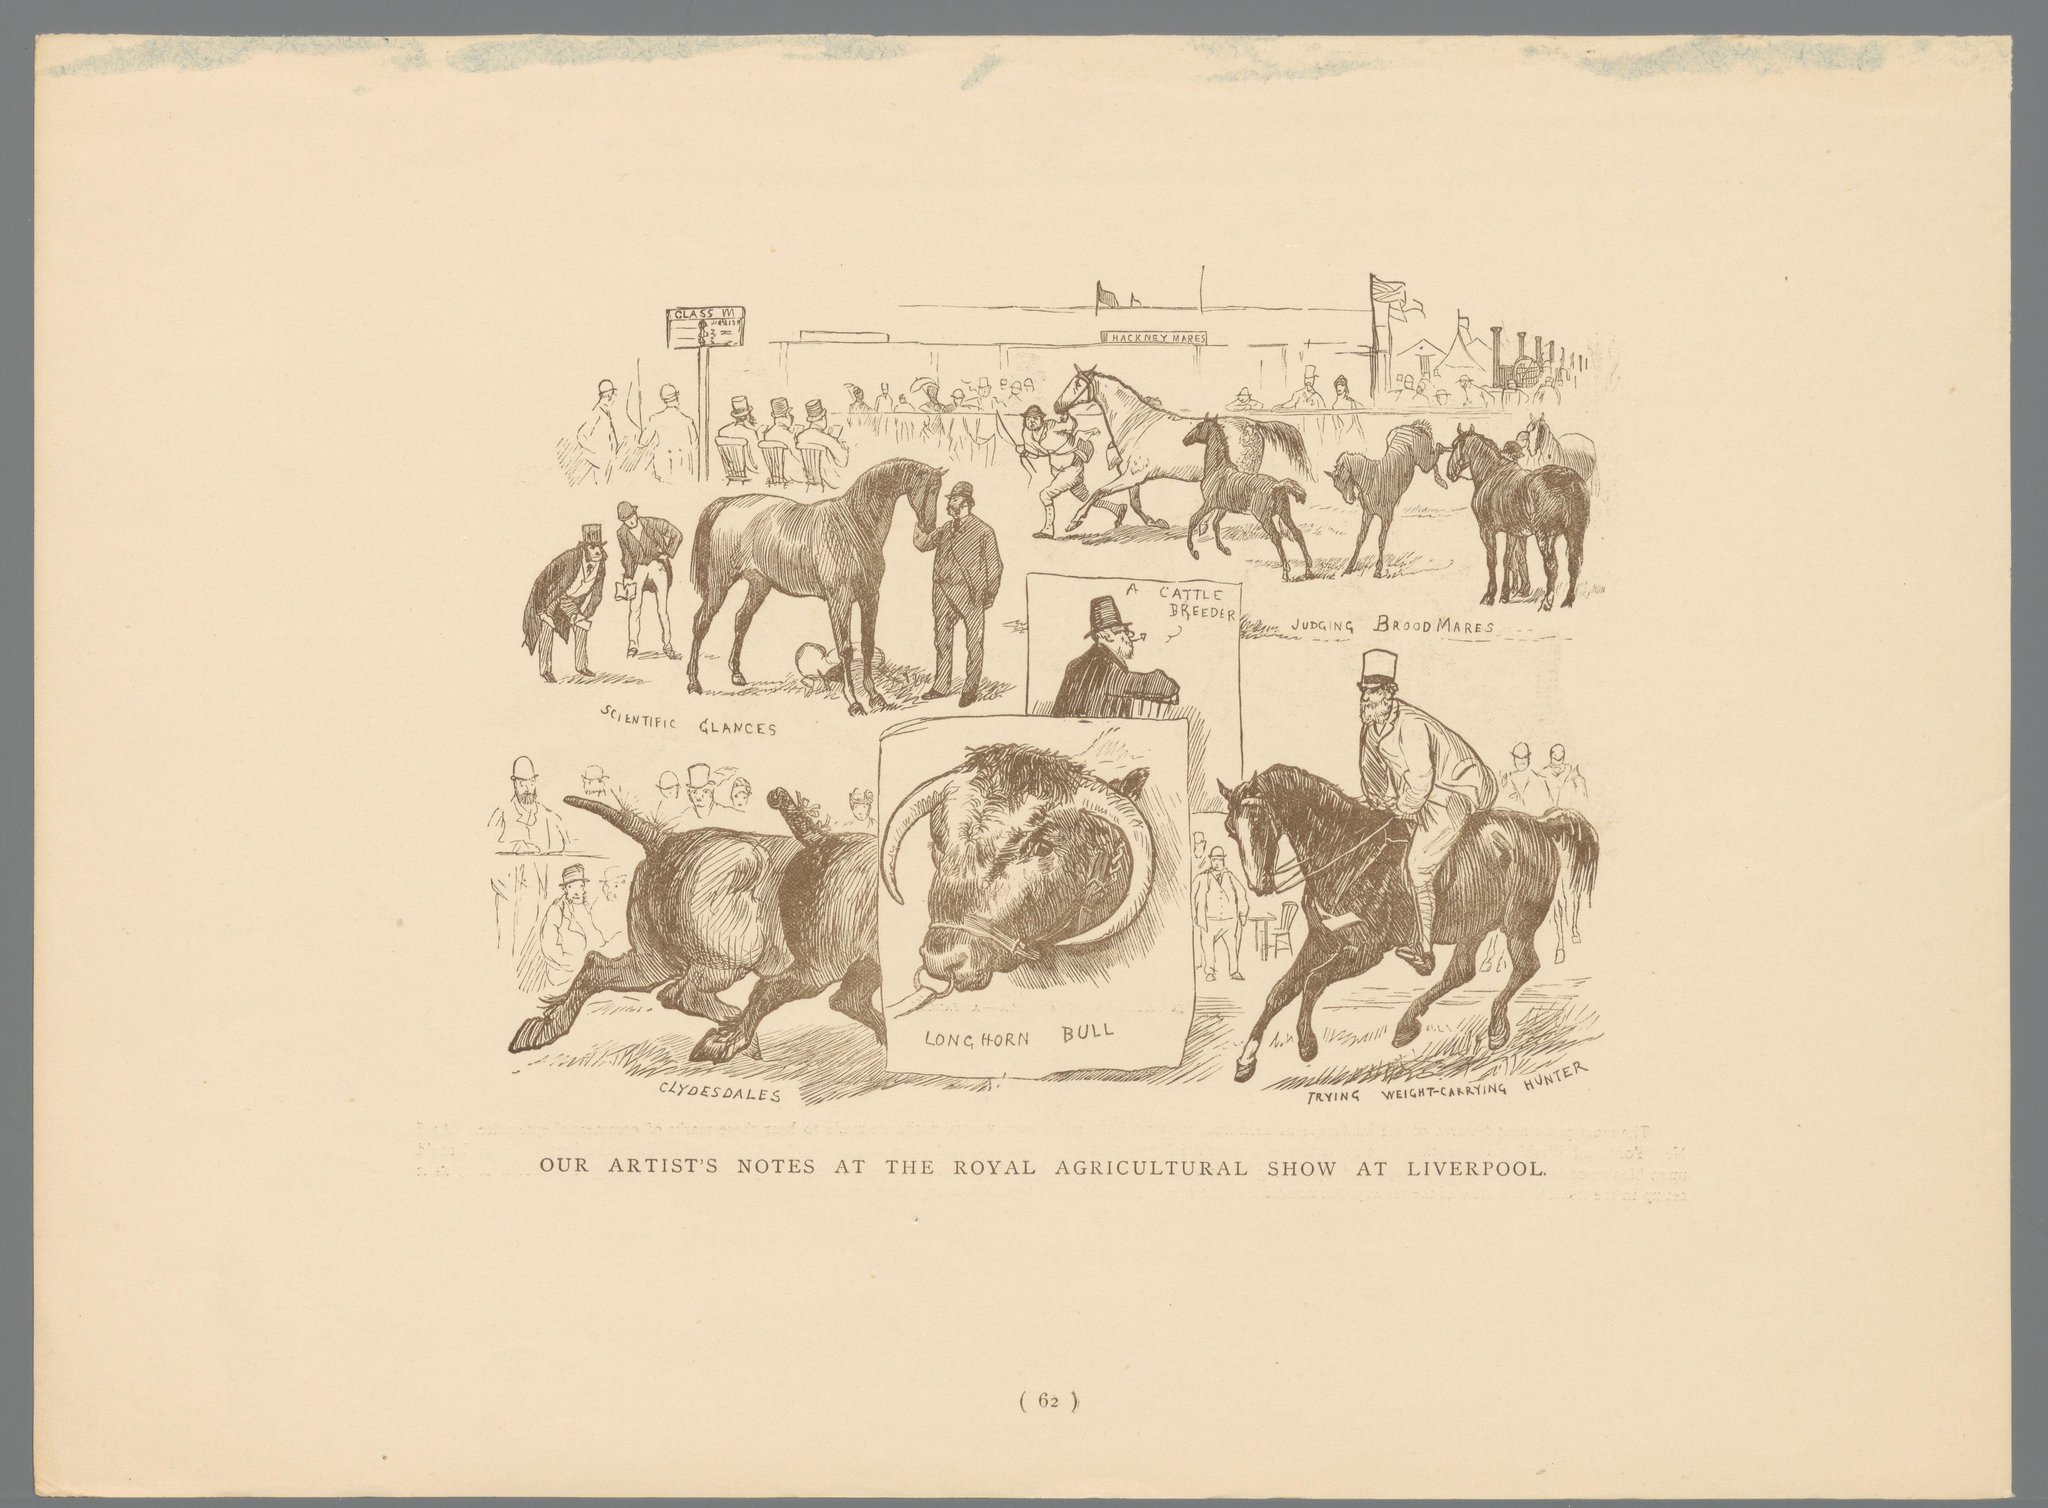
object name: print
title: Our artist's notes at the Royal Agricultural Show at Liverpool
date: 1889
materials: paper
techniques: letterpress printing, engraving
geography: london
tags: riding a horse, ass, or mule; rider, horseman, horse-racing, horse, liverpool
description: Prent uit: Gleanings from the Graphic. Londen: George Routledge & Sons, 1889. Dit werk is een bundel van diverse illustraties die eerder verschenen in verschillende jaargangen van het Engelse weekblad 'The Graphic'. De bundel is na het overlijden van Randolph Caldecott uitgegeven.